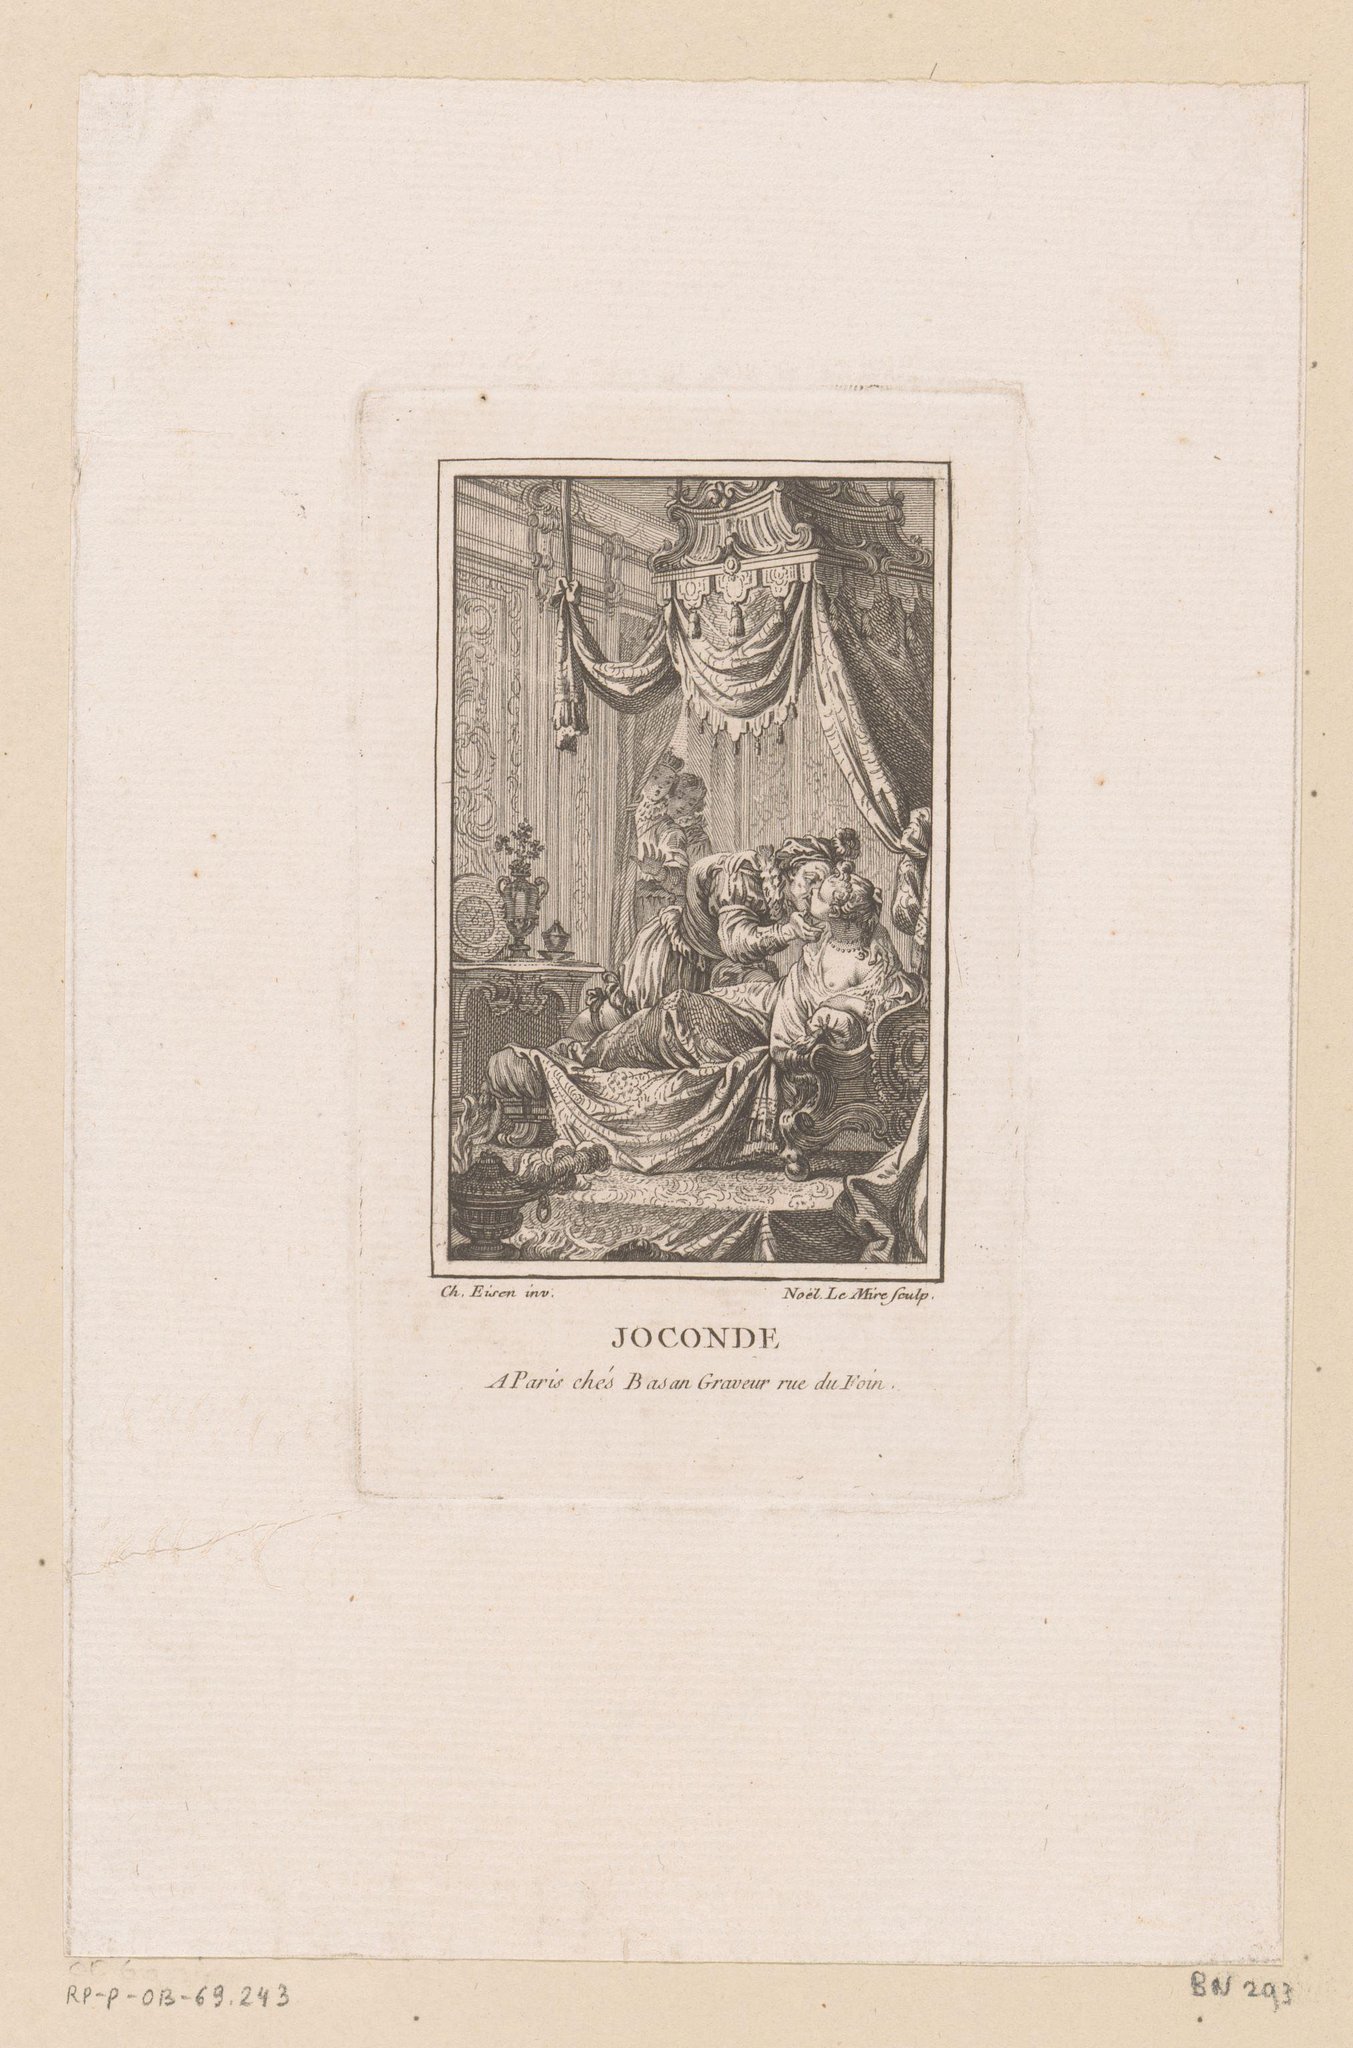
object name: book illustration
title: Kussend koppel op een bed, gadegeslagen door twee figuren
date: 1762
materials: paper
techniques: etching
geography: paris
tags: (lovers) kissing each other, bed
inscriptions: collector's mark: Lugt 240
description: Prent uit: Fontaine, Jean de La. Contes et nouvelles en vers. Parijs: Basan, 1762, dl. 2.